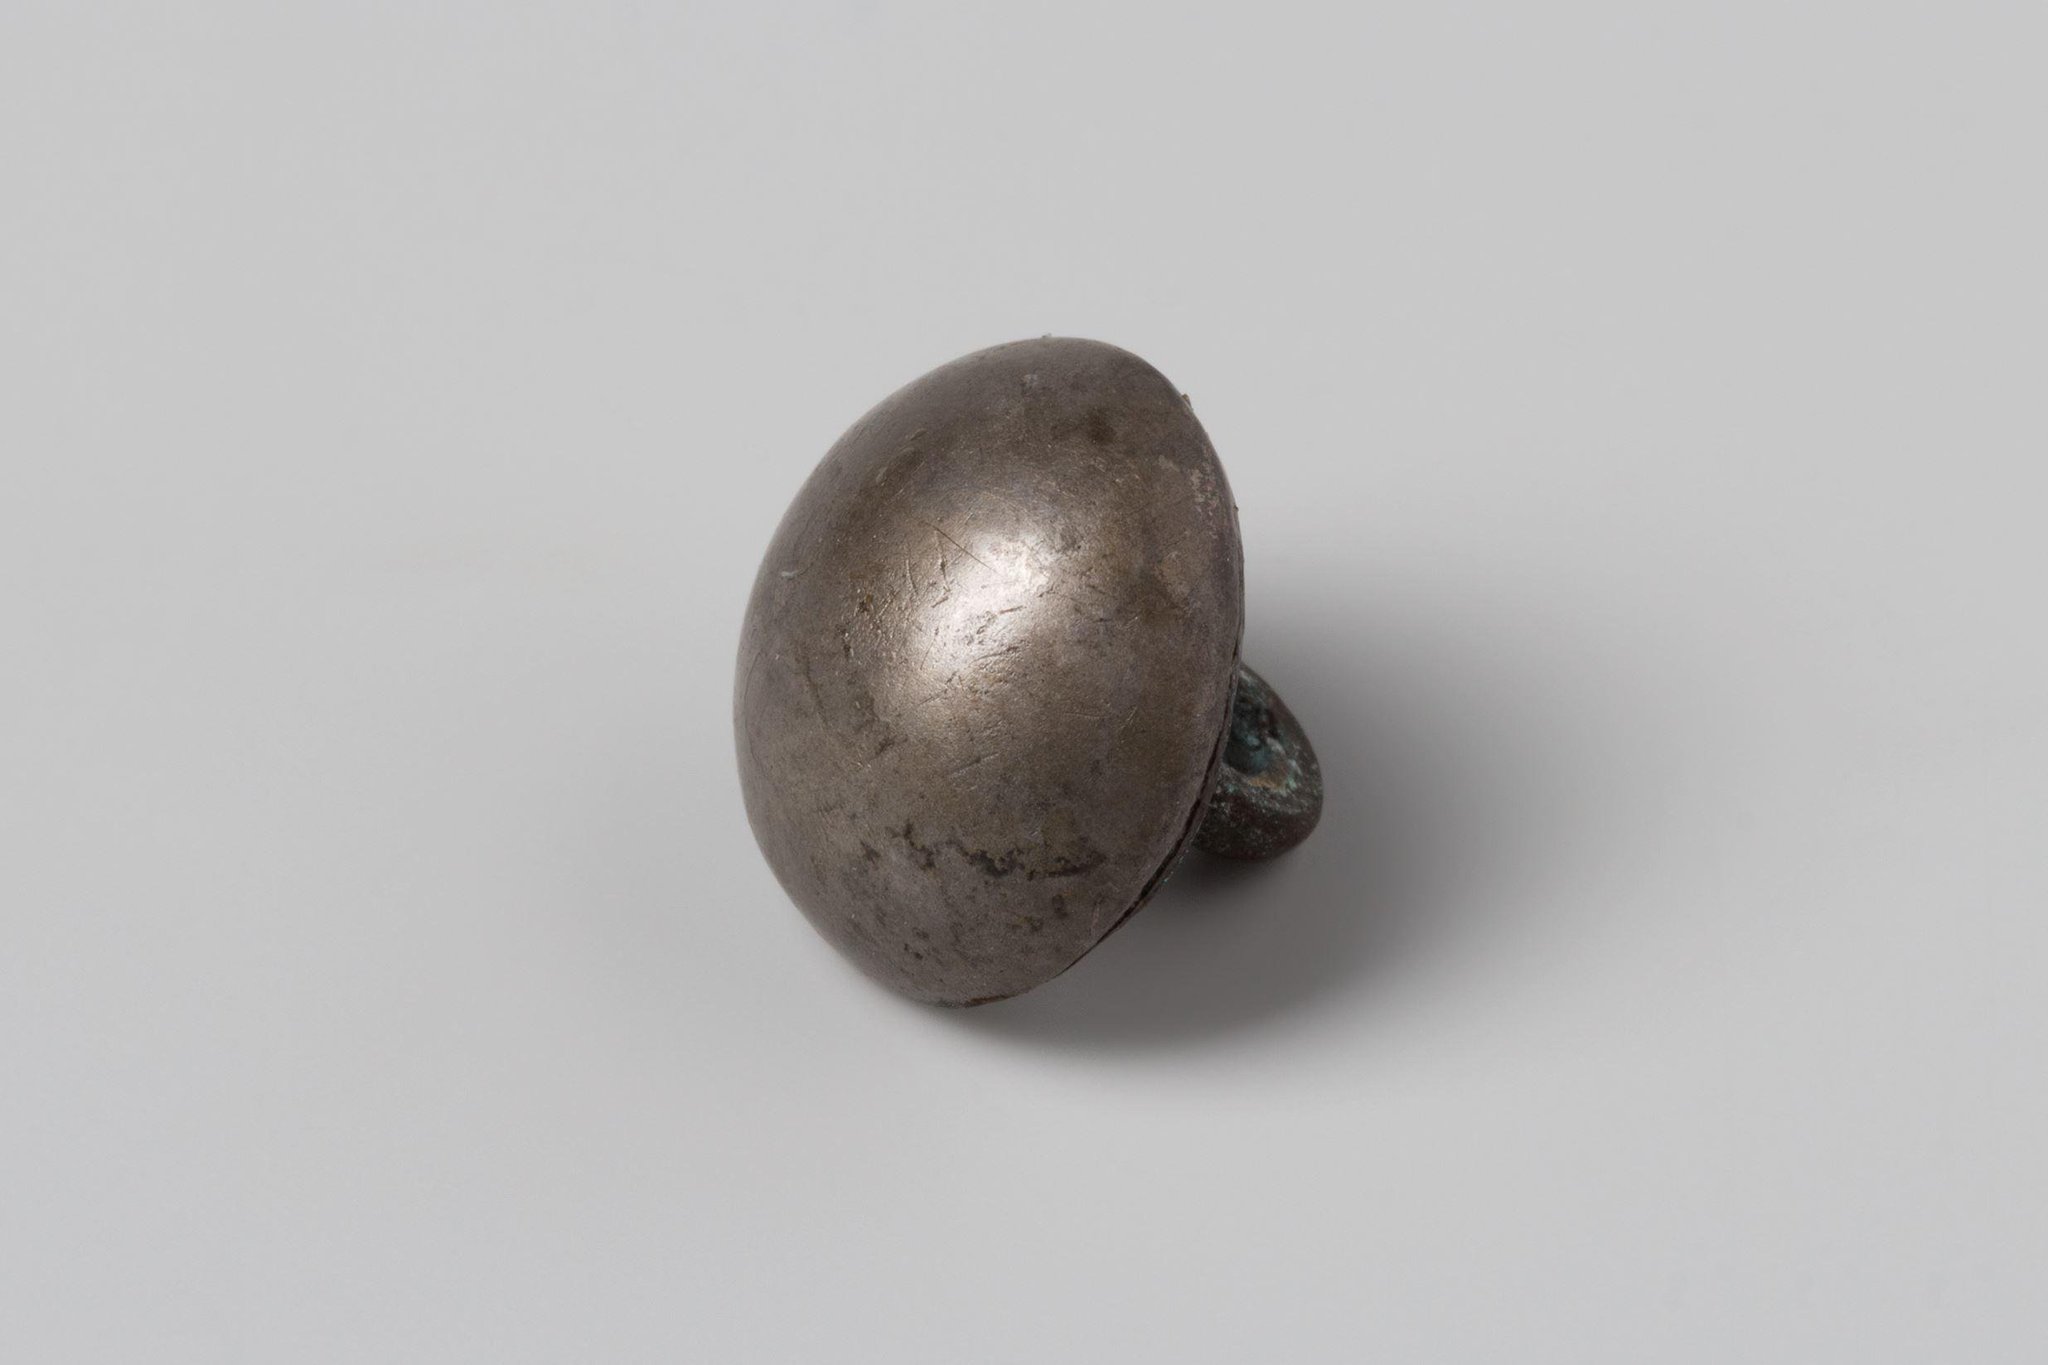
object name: button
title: Knoop uit het wrak van de Oost-Indiëvaarder Hollandia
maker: Anonymous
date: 1700-1743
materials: copper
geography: netherlands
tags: verenigde oostindische compagnie, hollandia (schip), annet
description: Knoop. Button; domed plain top, silver-plated, flat base, loop-shank, lead-filled.